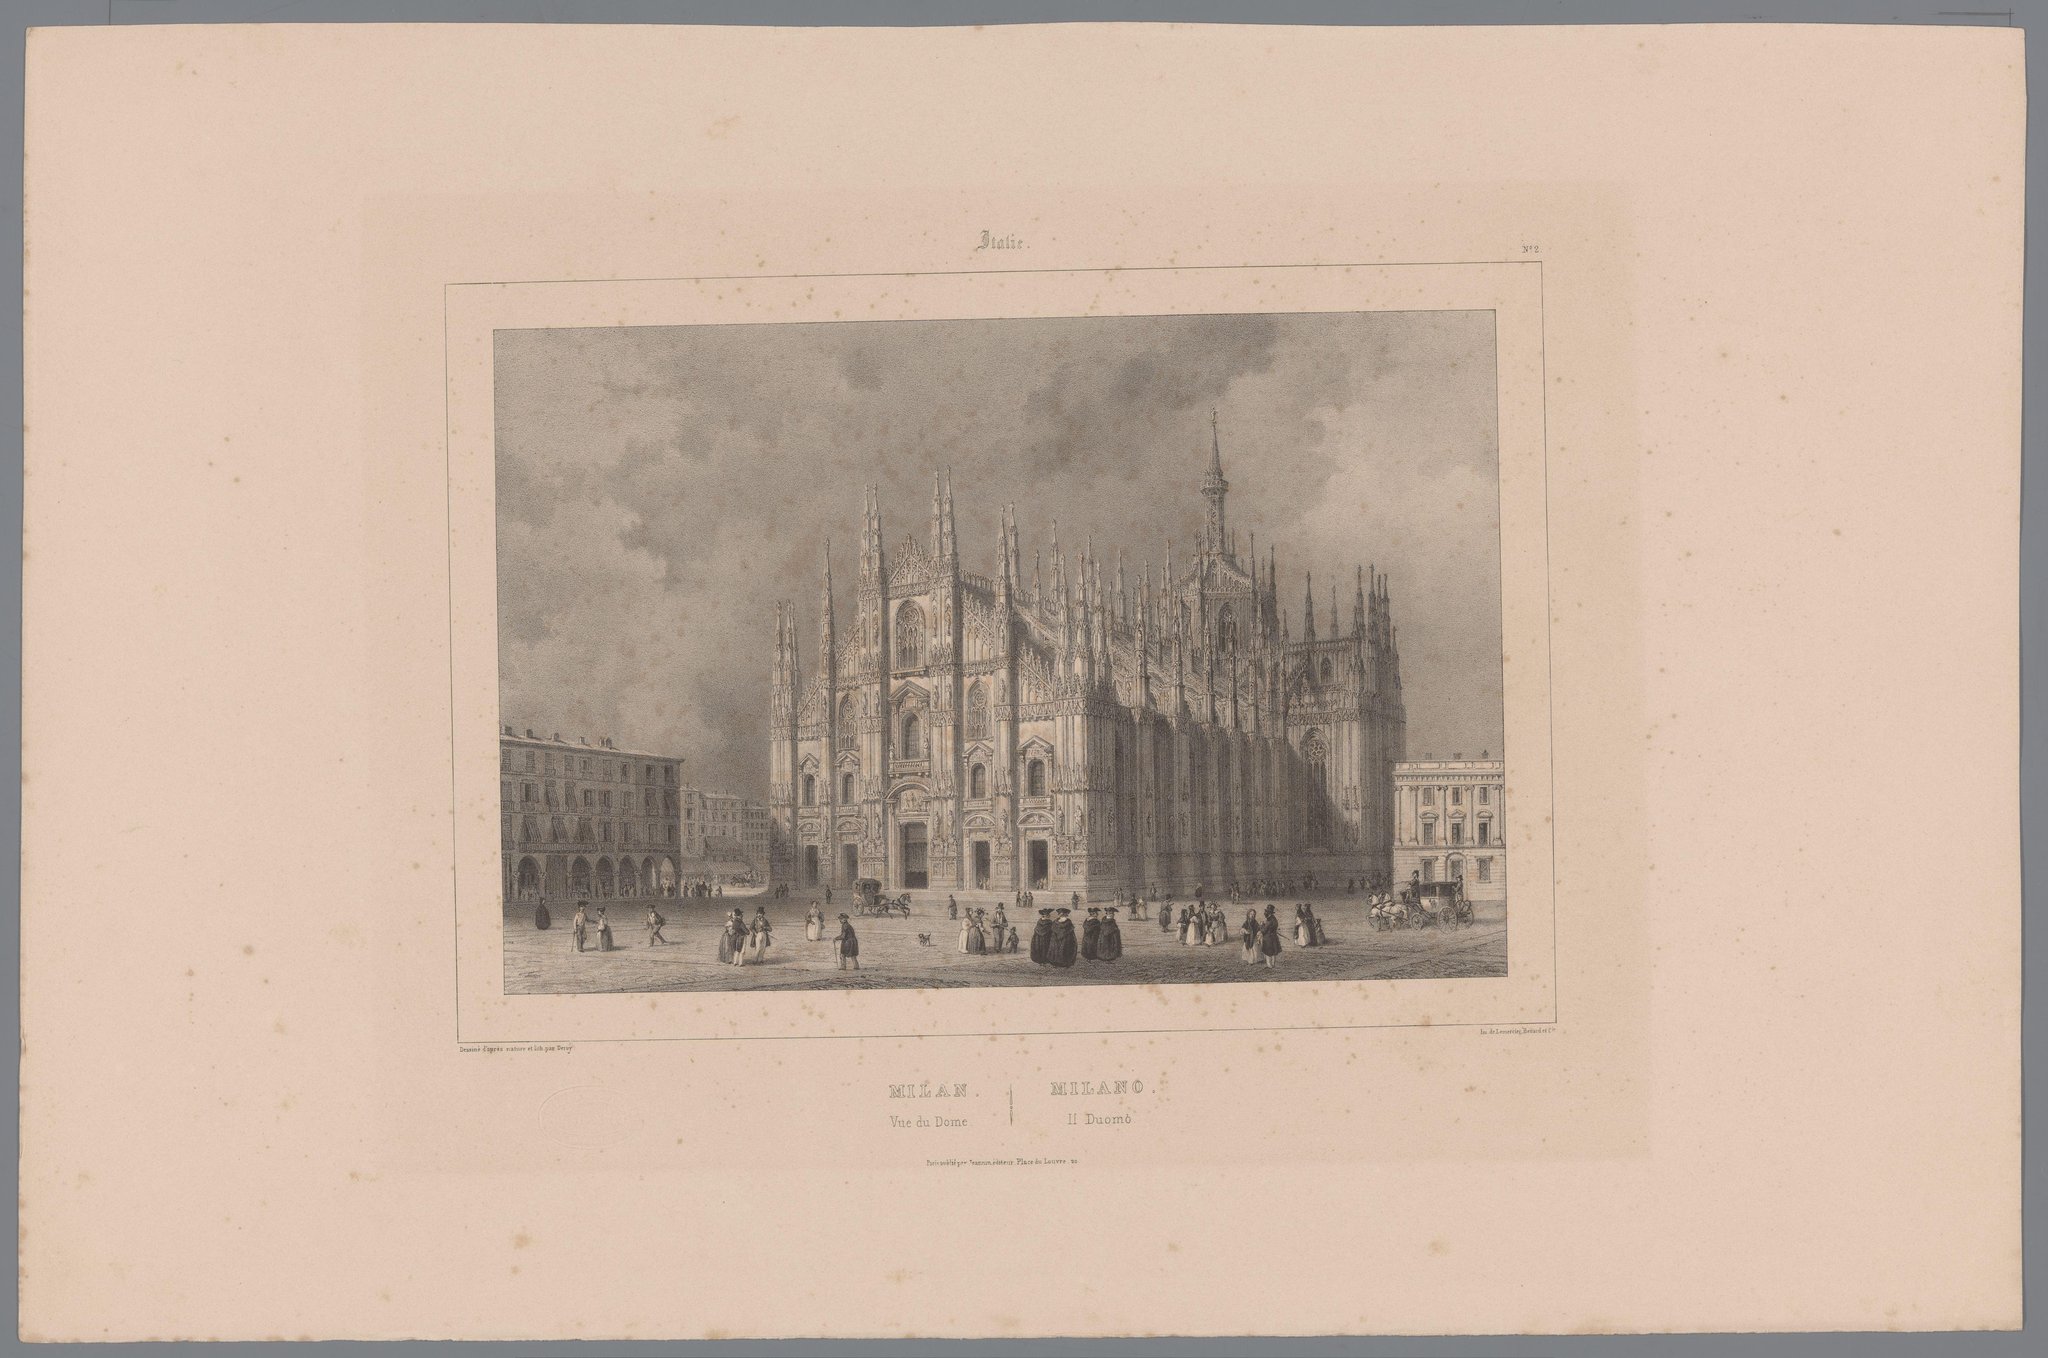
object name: print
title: Zicht op de Dom van Milaan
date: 1838-1841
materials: paper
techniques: lithograph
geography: paris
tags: church (exterior)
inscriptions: collector's mark: Lugt 2228a, check stamp: Lugt 1397c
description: Prent maakt deel uit van een omslag met zes prenten.